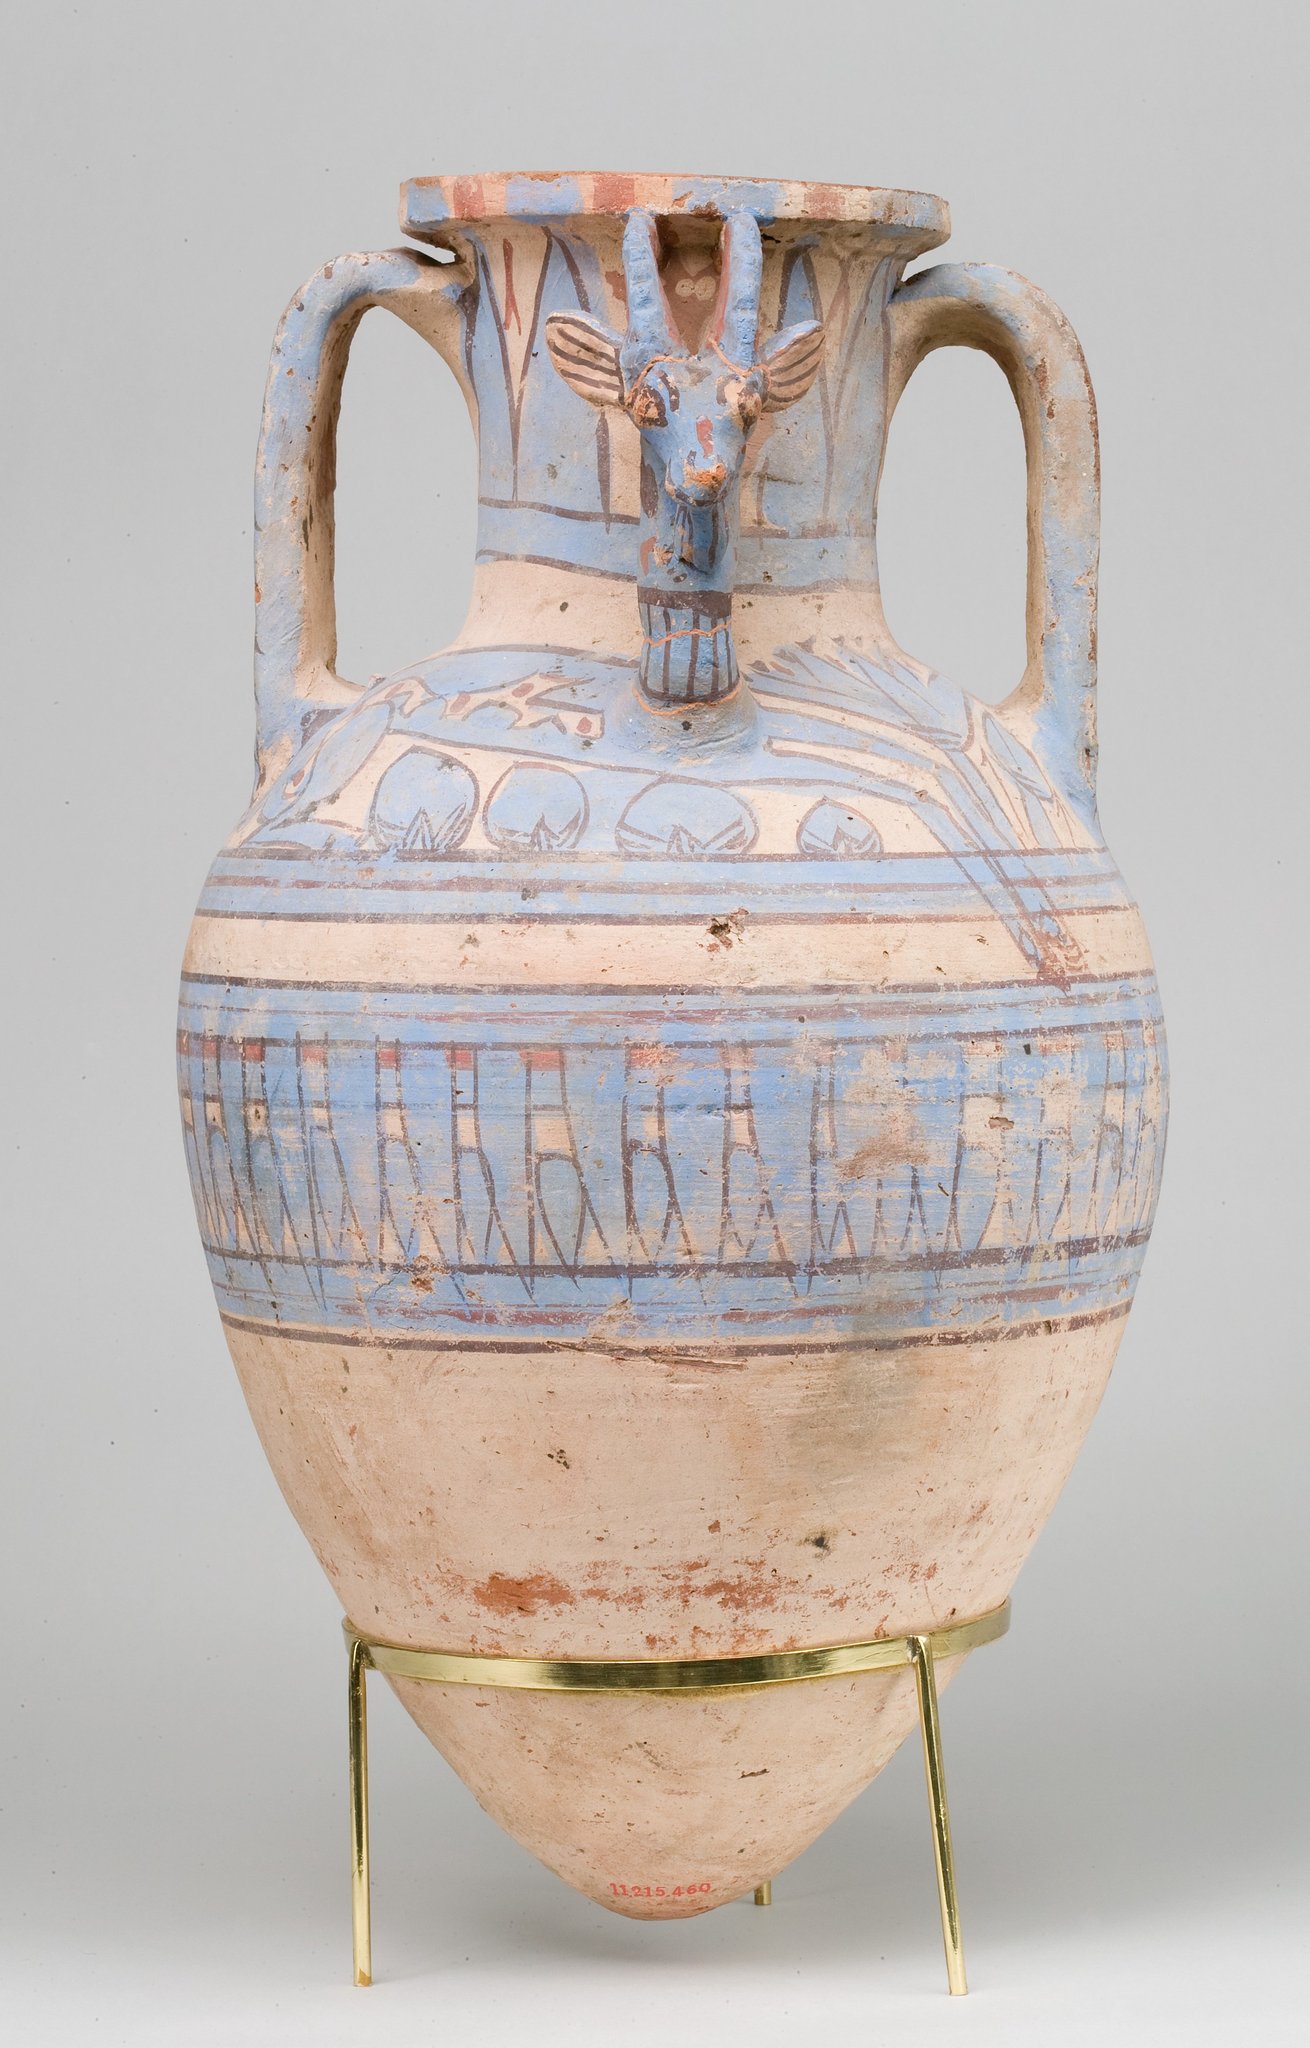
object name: amphora, ibex, blue painted ware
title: Blue-Painted Ibex Amphora from Malqata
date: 1390-1352 BCE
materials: paint, pottery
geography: egypt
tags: ibex